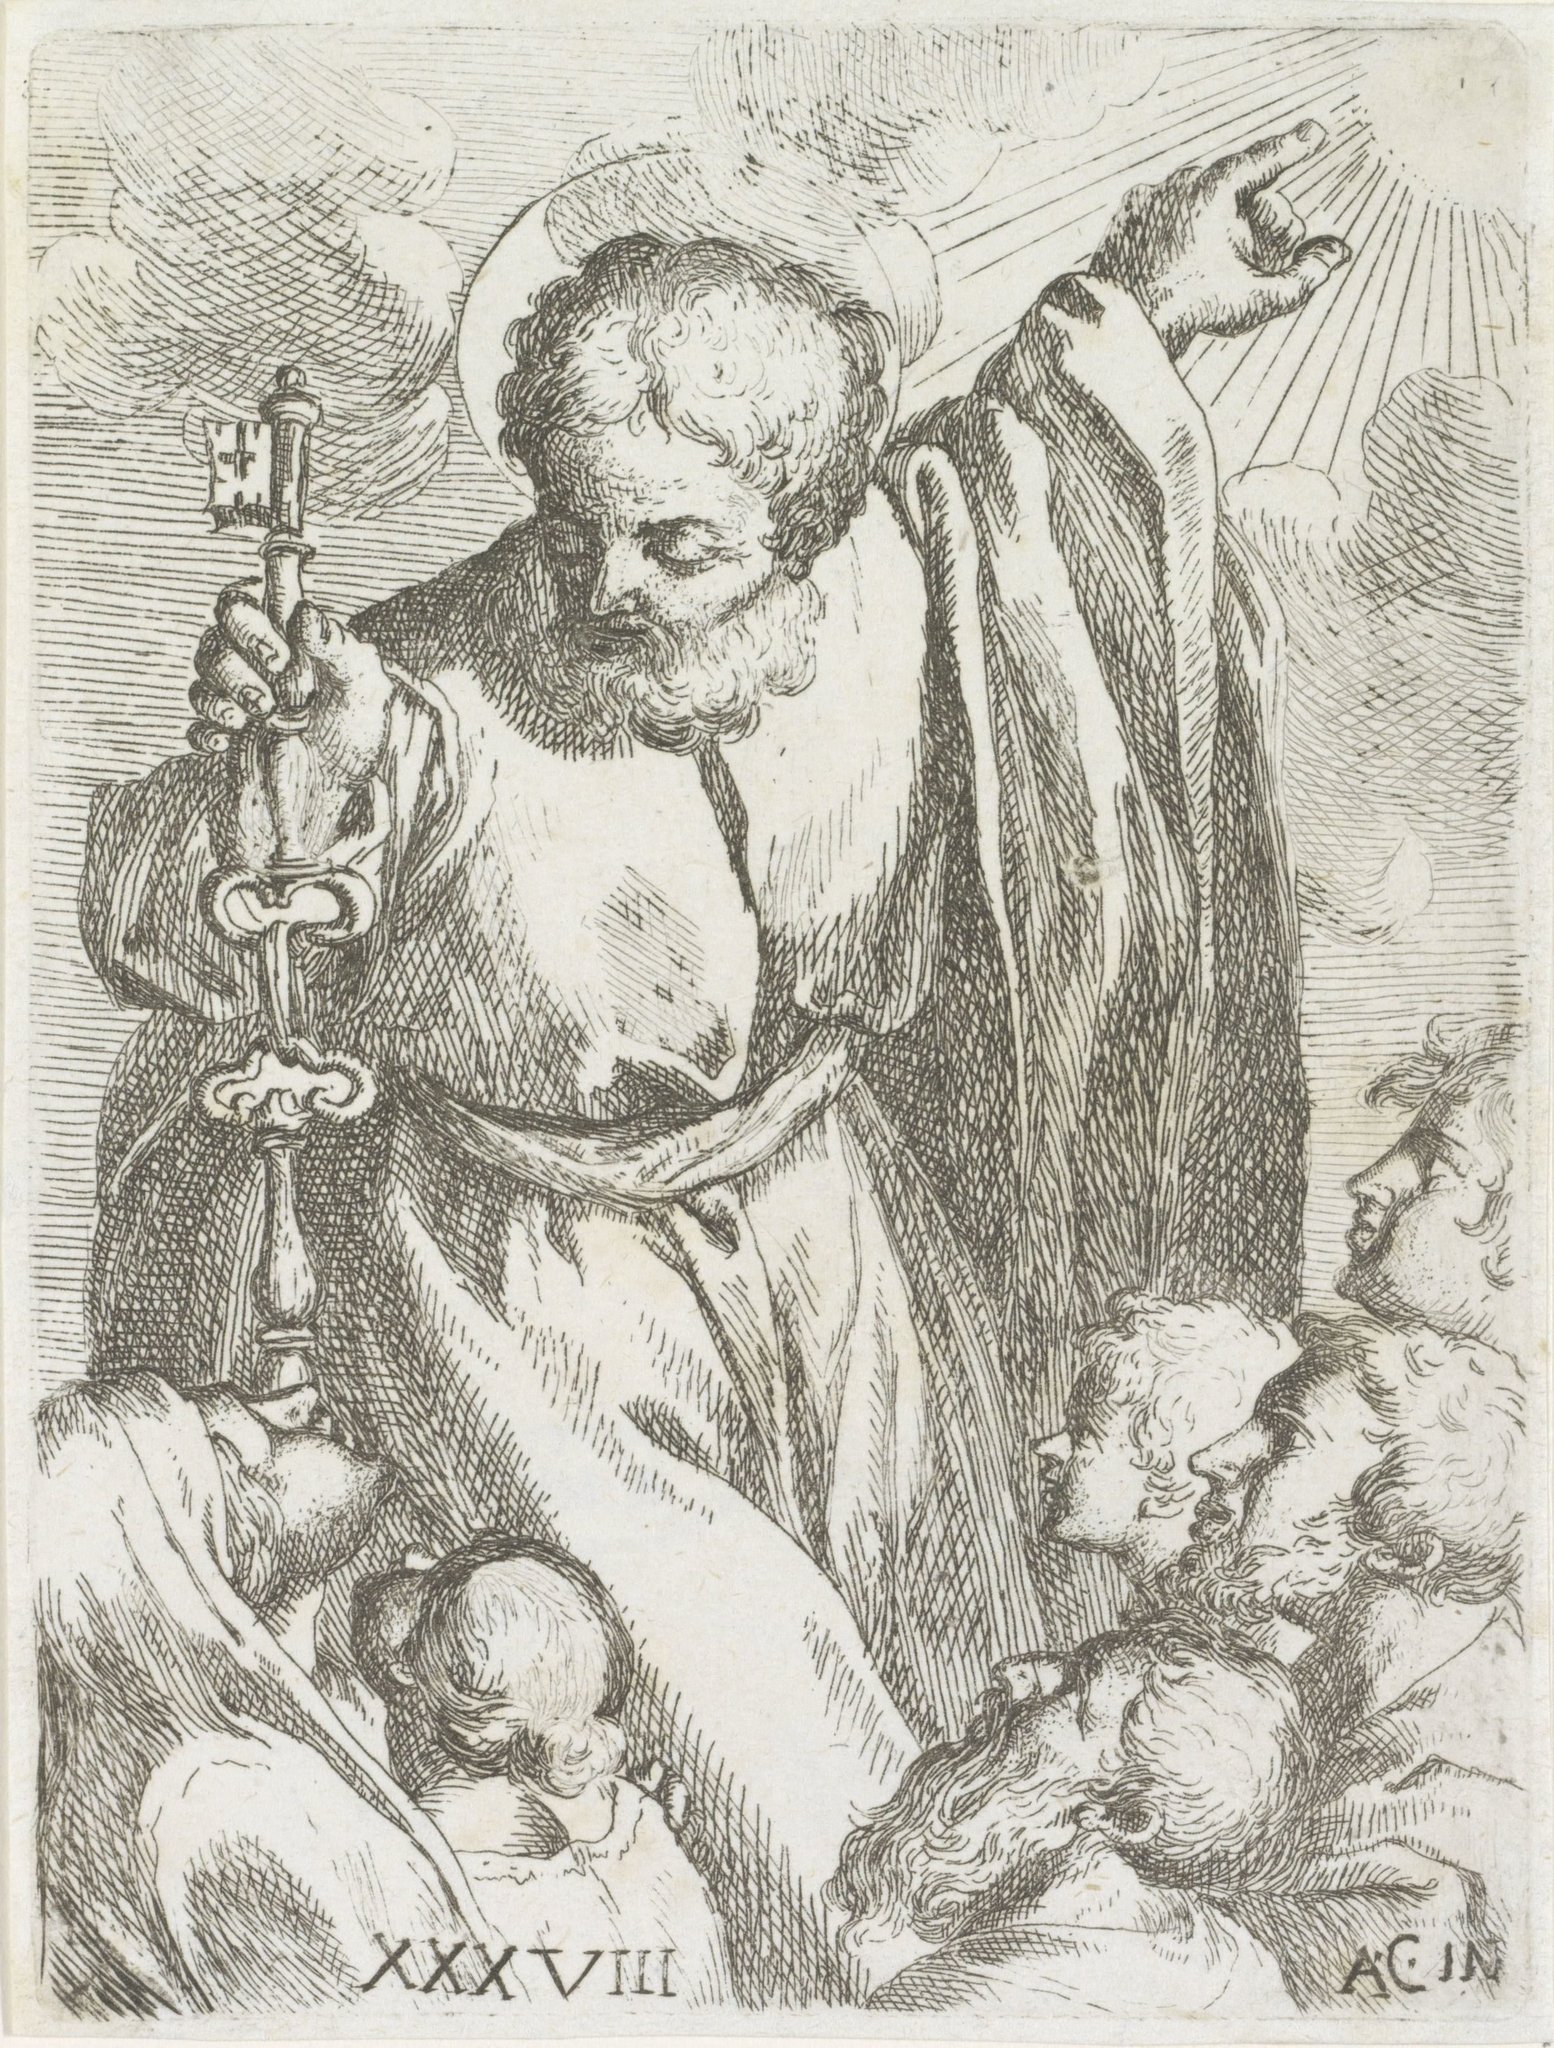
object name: print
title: De heilige Petrus en gelovigen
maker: marcantonio bellavia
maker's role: painter, print maker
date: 1660-1680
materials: paper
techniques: etching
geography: italy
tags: the apostle peter, first bishop of rome; possible attributes: book, cock, (upturned) cross, (triple) crozier, fish, key, scroll, ship, tiara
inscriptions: collector's mark: Lugt 2760, collector's mark: Lugt 2228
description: De heilige Petrus, wijzend naar de hemel met zijn linkerhand. In zijn rechterhand twee sleutels. Op de voorgrond gelovigen die naar hem luisteren. Genummerd midden onder: XXXVIII.